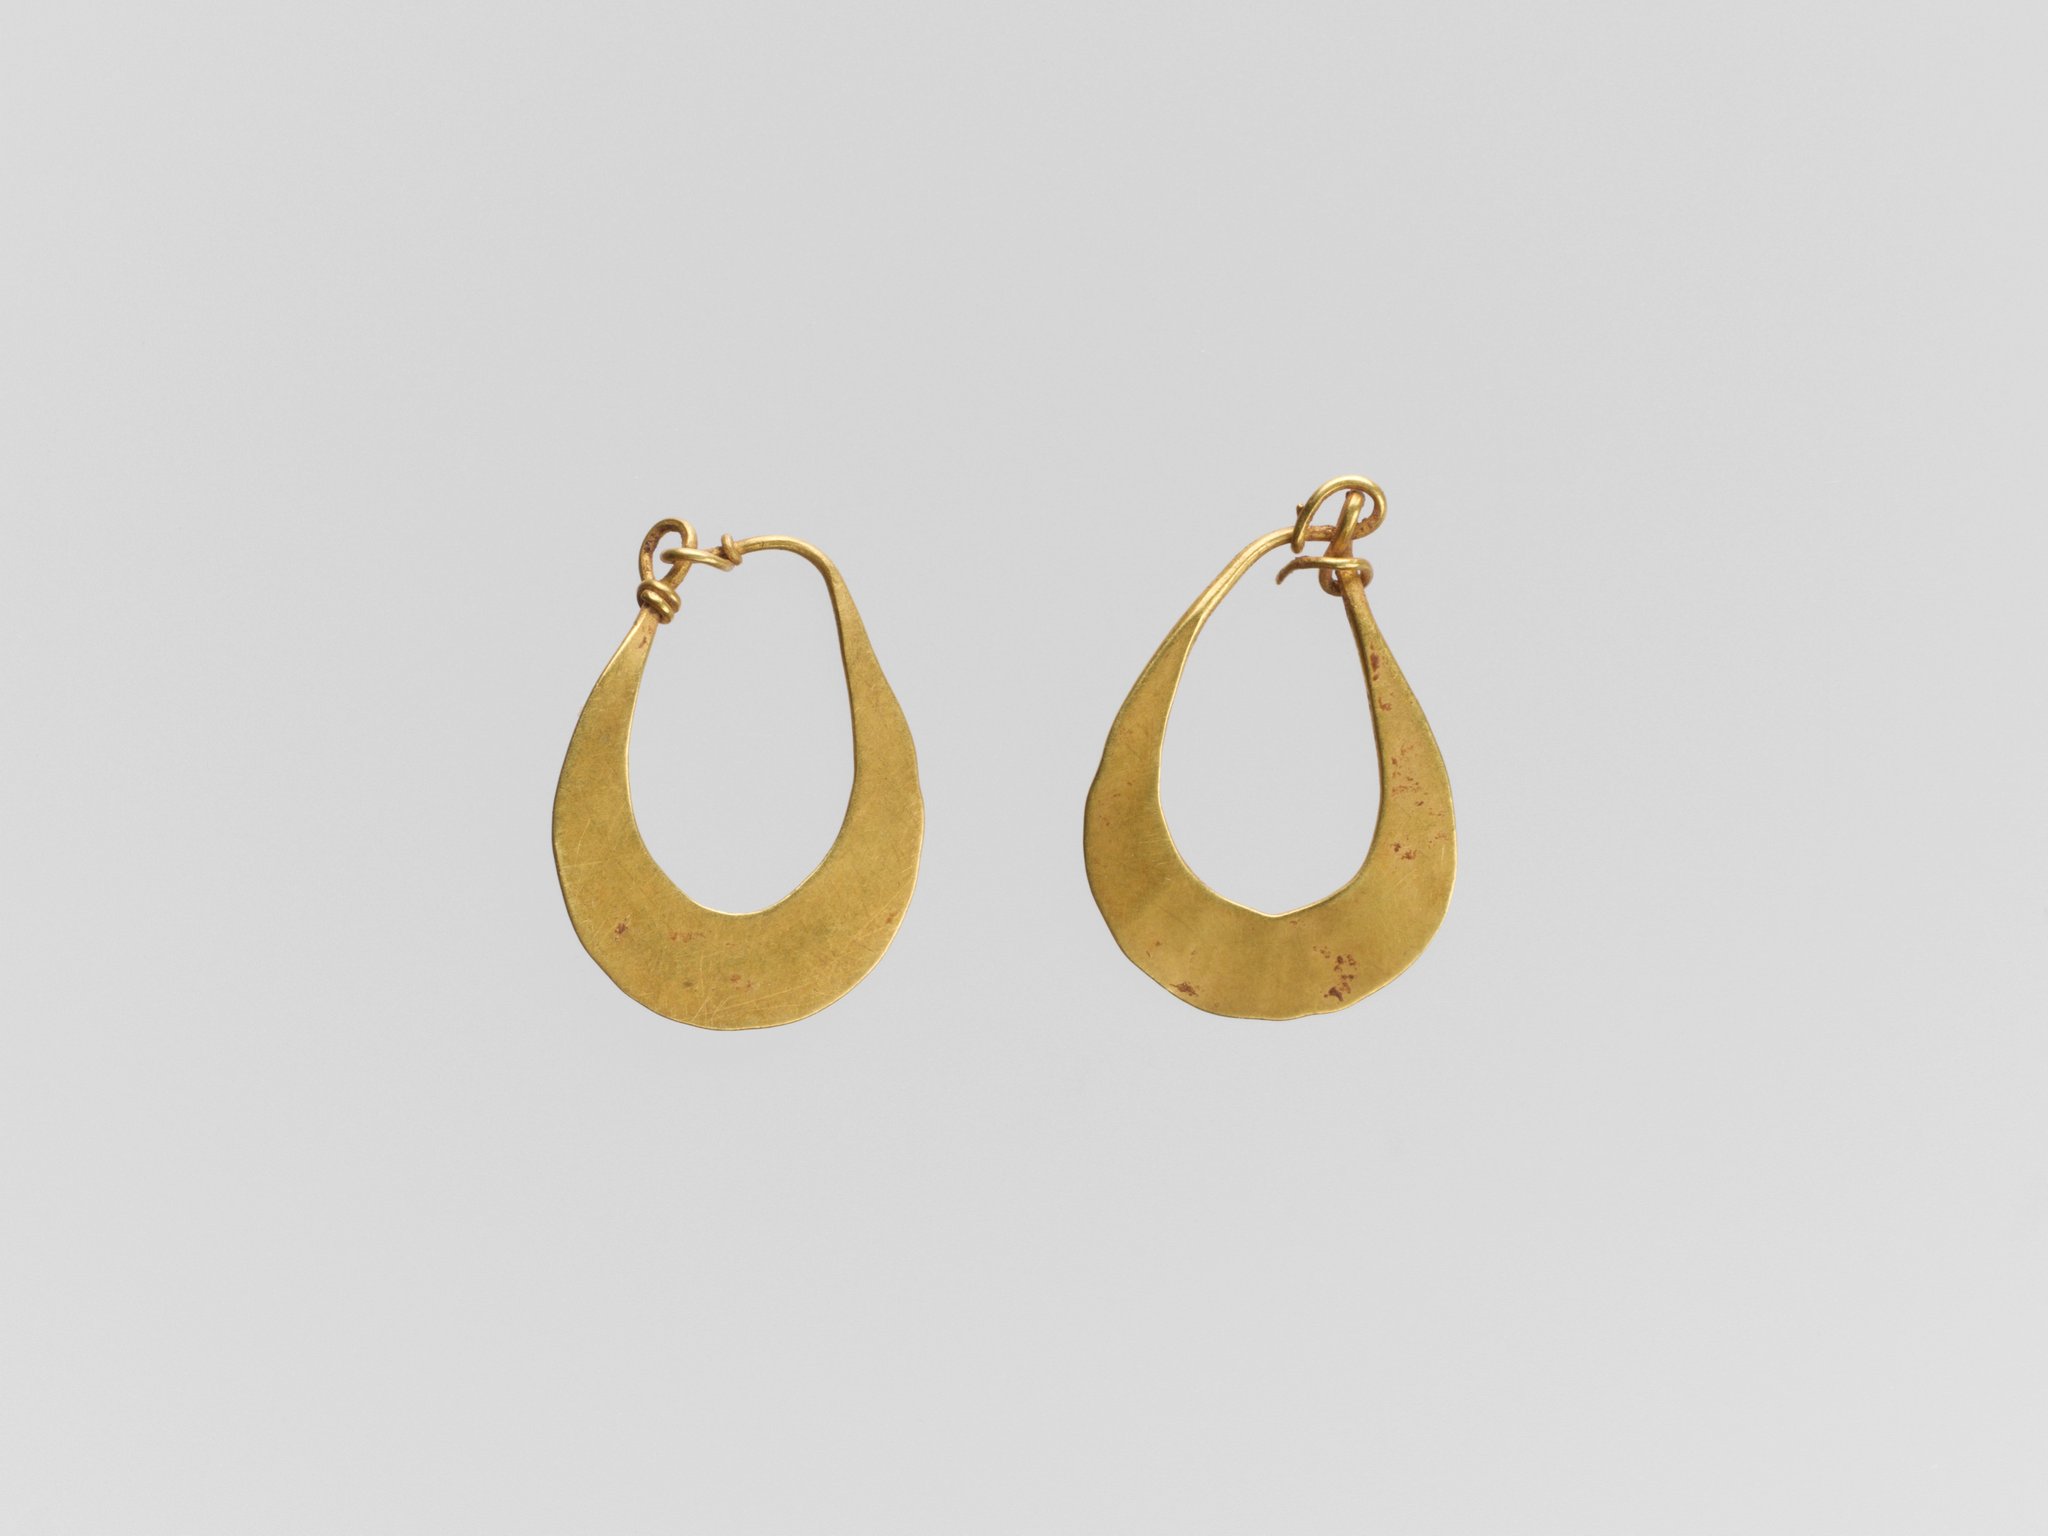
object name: earring, crescent shaped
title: Gold crescent-shaped earring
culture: cypriot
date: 500 BCE-100 CE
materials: gold